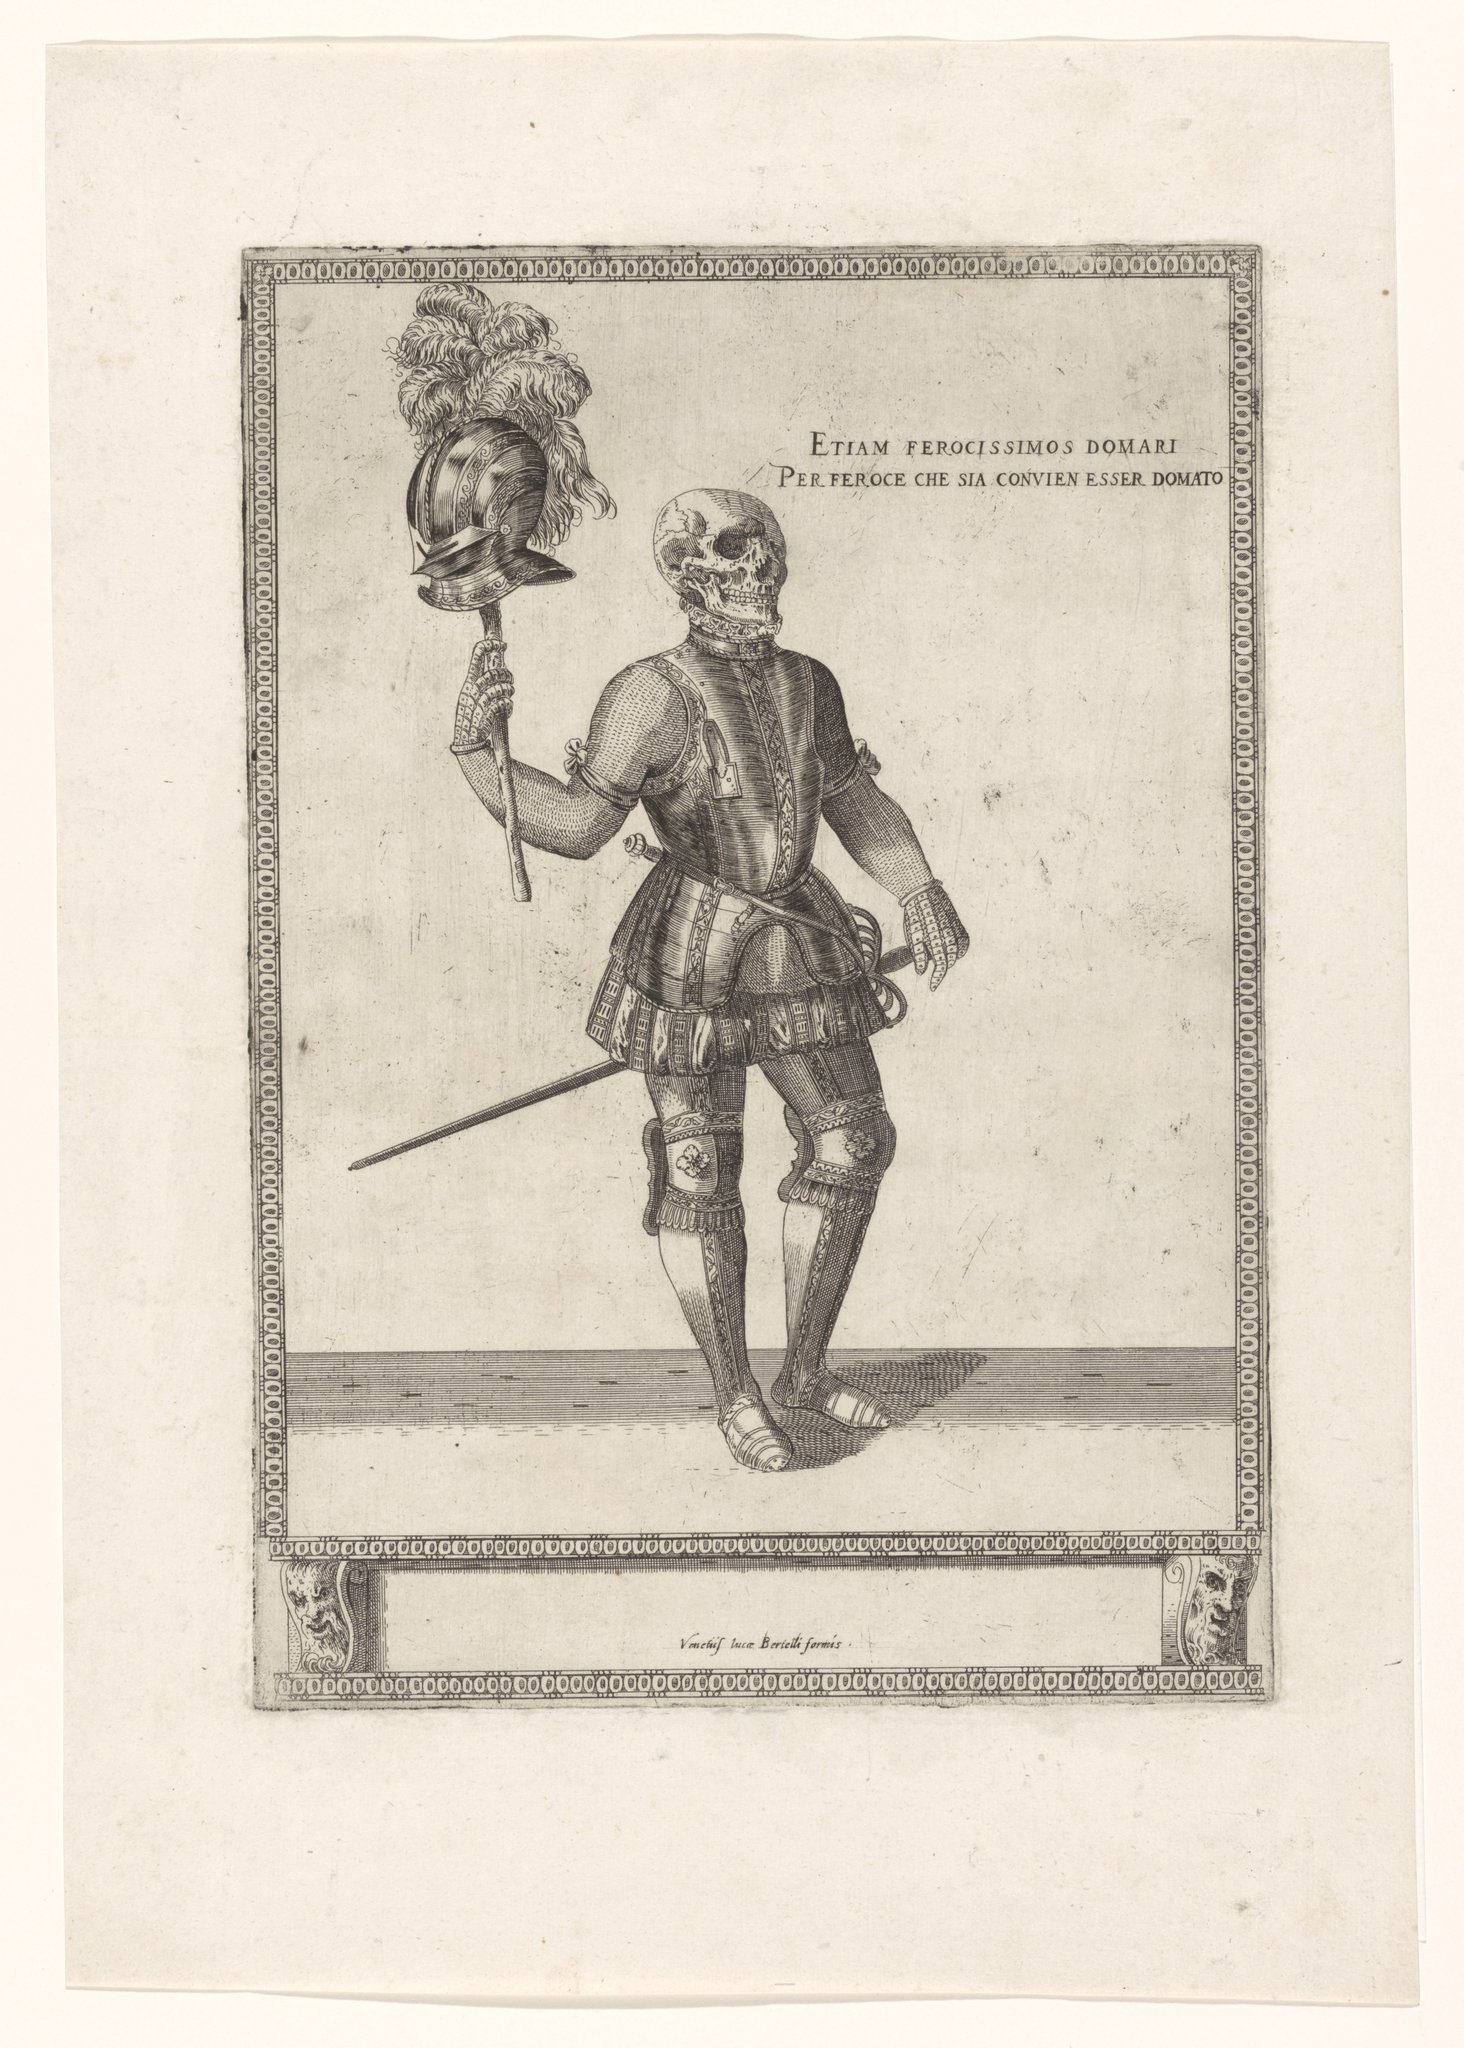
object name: print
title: Armed Skeleton, Allegory of Death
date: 1565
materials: paper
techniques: etching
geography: italy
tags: death as skeleton, armour, 'vanitas' symbols, knight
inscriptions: collector's mark: Lugt 2760, watermark:, inscription: ‘ETIAM FERROCISSIMOS DOMARI/ PER FERROCE CHE SIA CONVIEN ESSER DOMATO’, collector's mark: Lugt 2228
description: This sinister allegory of death is inscribed: ‘Even the most violent men are tamed by Death, which is more violent still.’ The print was meant to hang on a wall, given the printed frame with which the Venetian publisher marketed it. As a result, most examples will have been the worse for wear and discarded. As far as is known, this is the only surviving impression.